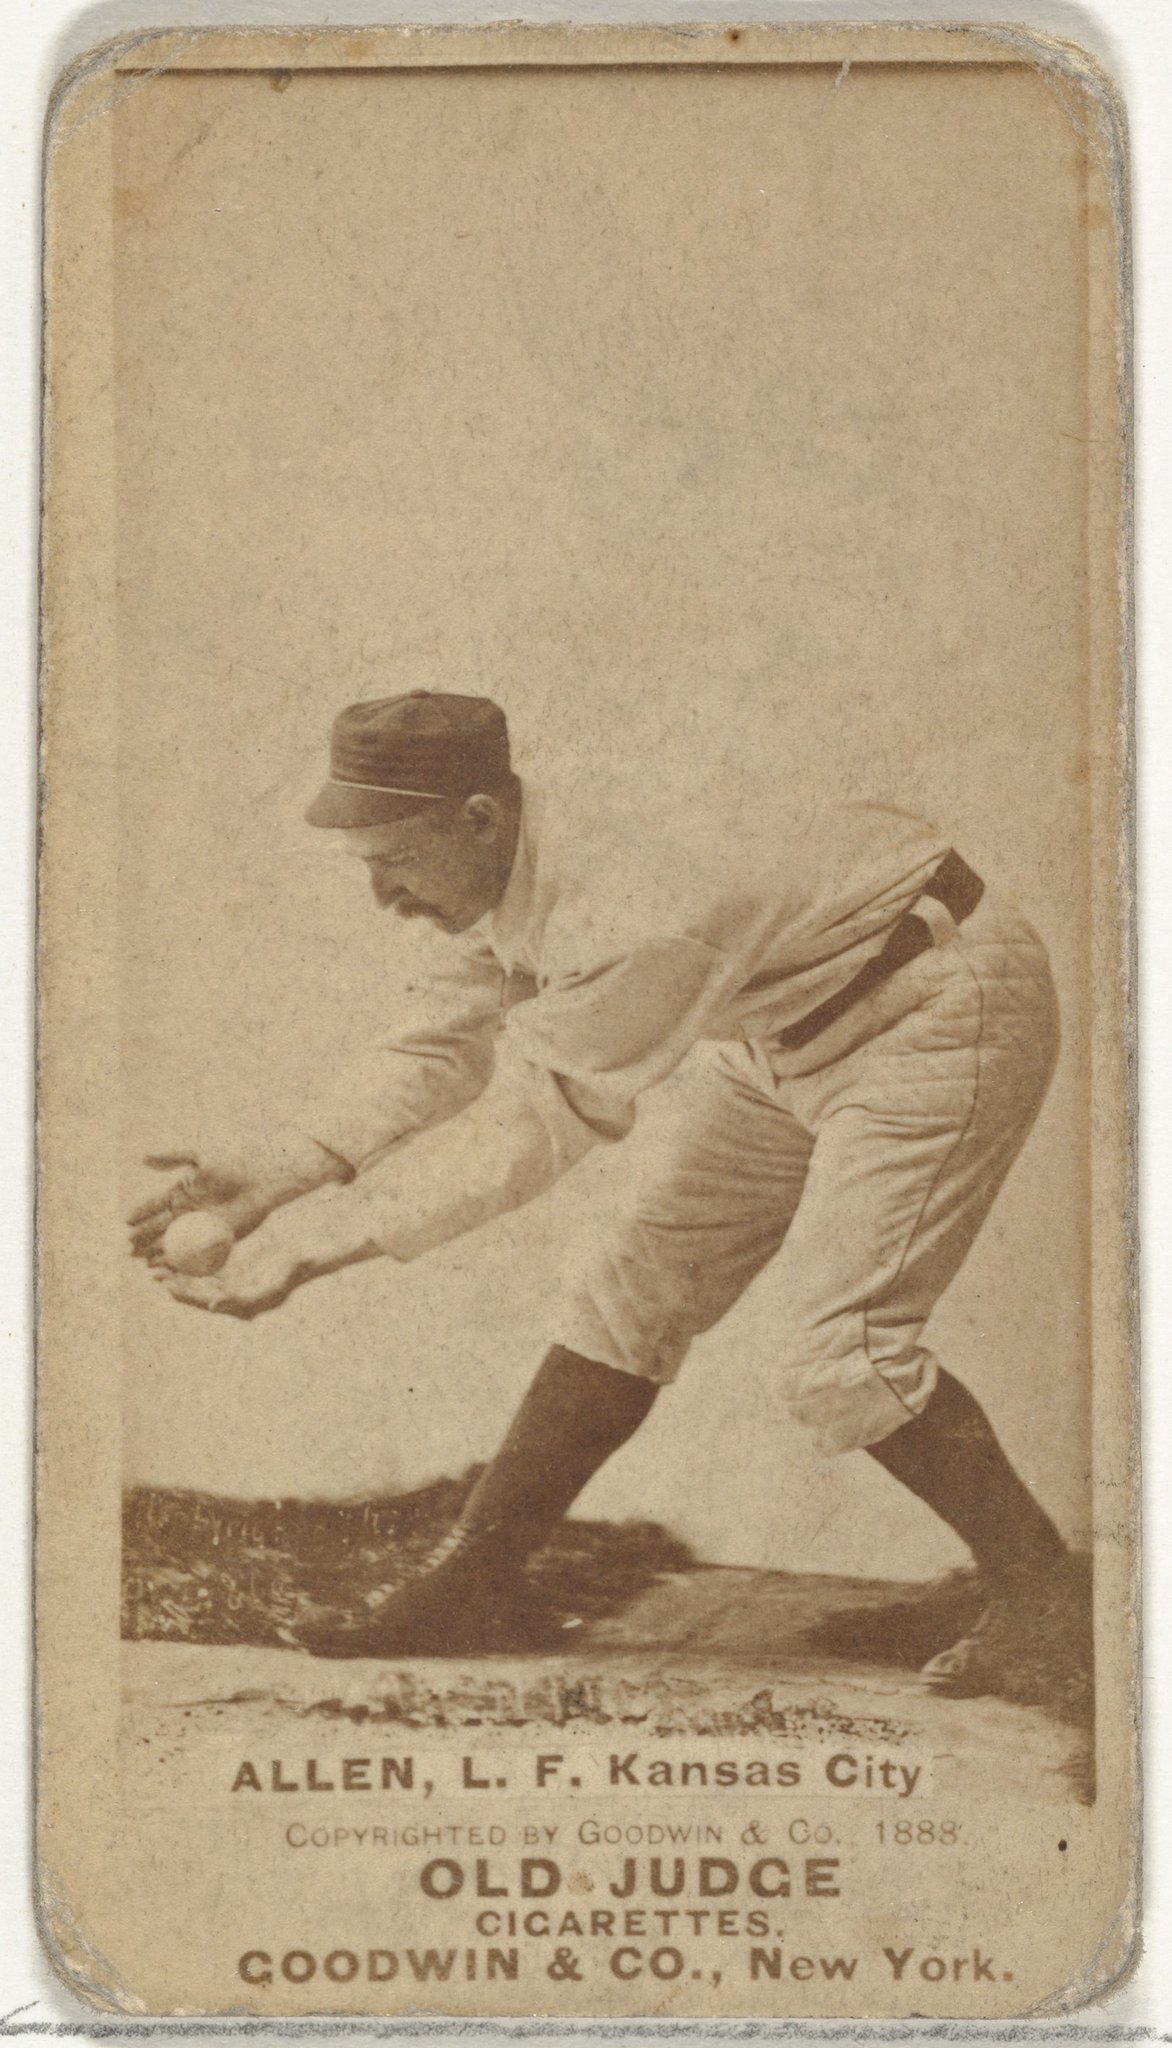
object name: baseball card, photograph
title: Myron Smith Allen, Left Field, Kansas City Cowboys, from the Old Judge series (N172) for Old Judge Cigarettes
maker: goodwin & company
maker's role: publisher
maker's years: 1850-1950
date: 1888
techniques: albumen silver print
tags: men,portraits,baseball,athletes